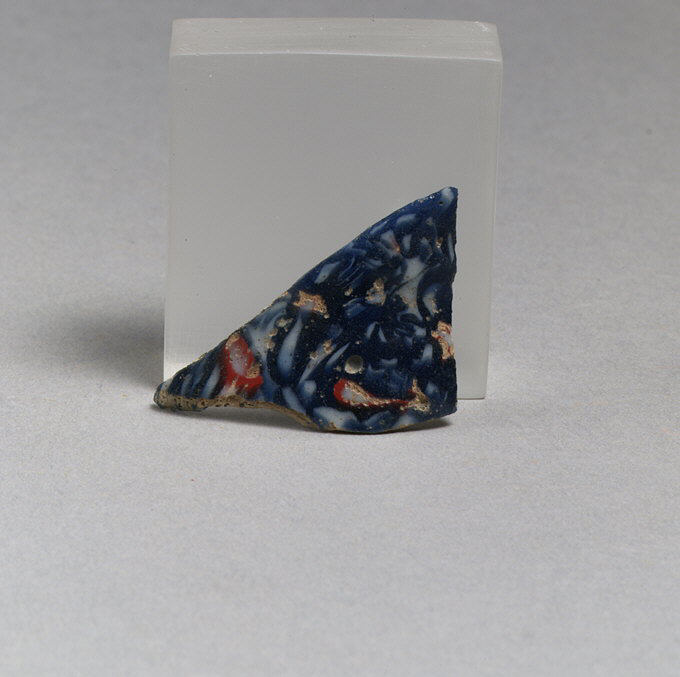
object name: fragment, mosaic bowl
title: Glass mosaic carinated bowl fragment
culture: roman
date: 34 BCE-33 CE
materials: glass